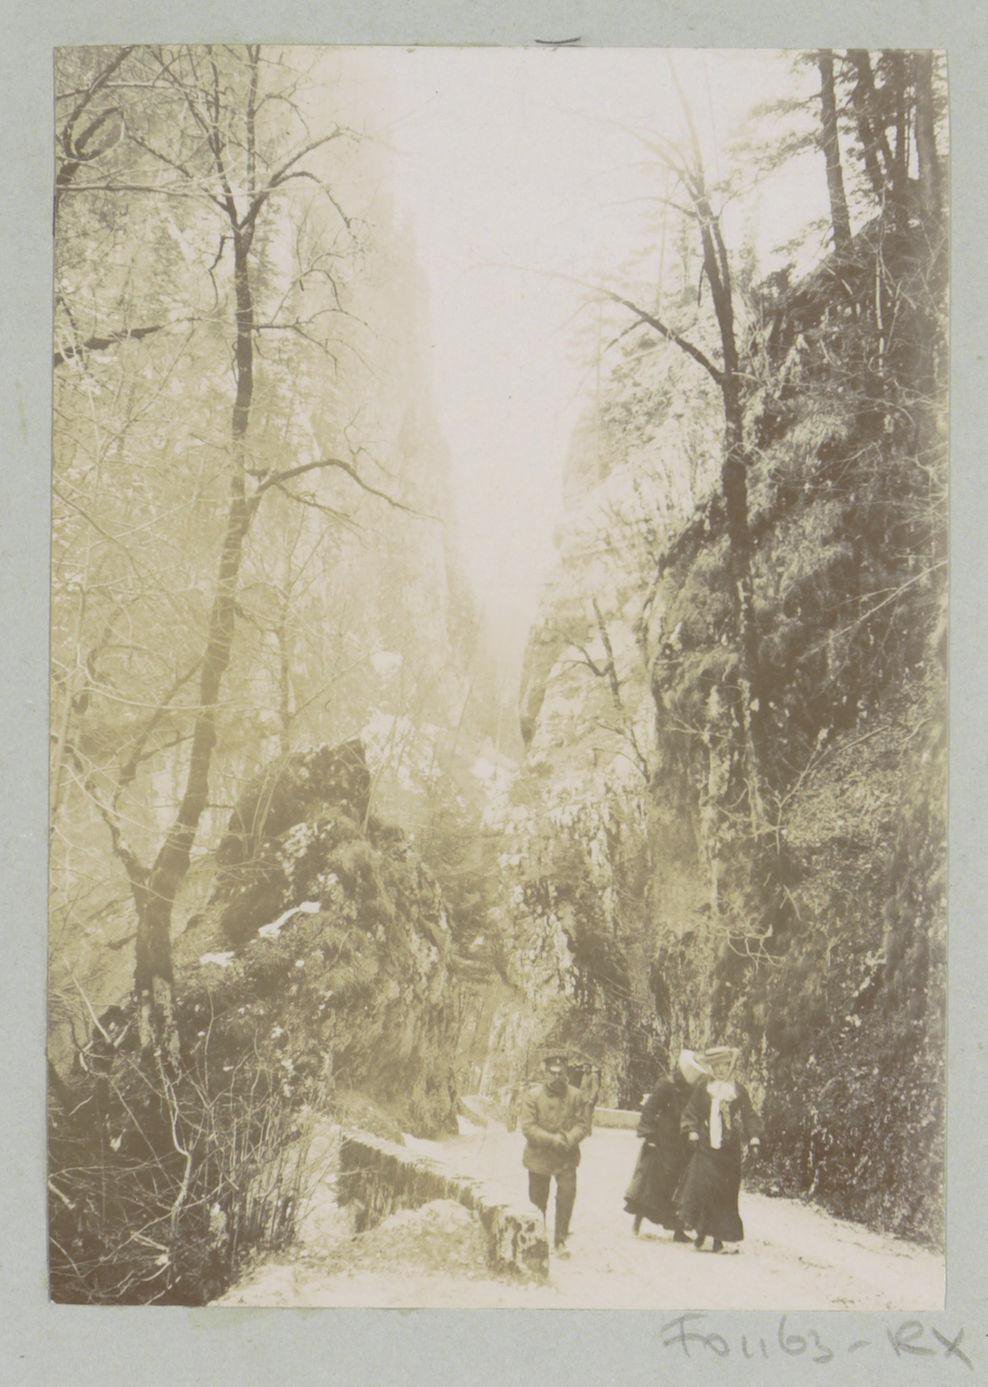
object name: photograph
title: Drie personen lopend op een bergweg, vermoedelijk op de Route de la Grande Chartreuse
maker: delizy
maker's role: manufacturer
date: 1903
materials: paper, photographic support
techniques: gelatin silver print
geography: chartreuse mountains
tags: walking, hiking (recreation), road, path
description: Onderdeel van Fotoalbum van een Franse amateurfotograaf met opnames van uitstapjes in Frankrijk, Spanje, België, Luxemburg en Nederland, de eerste automobielen en autoraces.